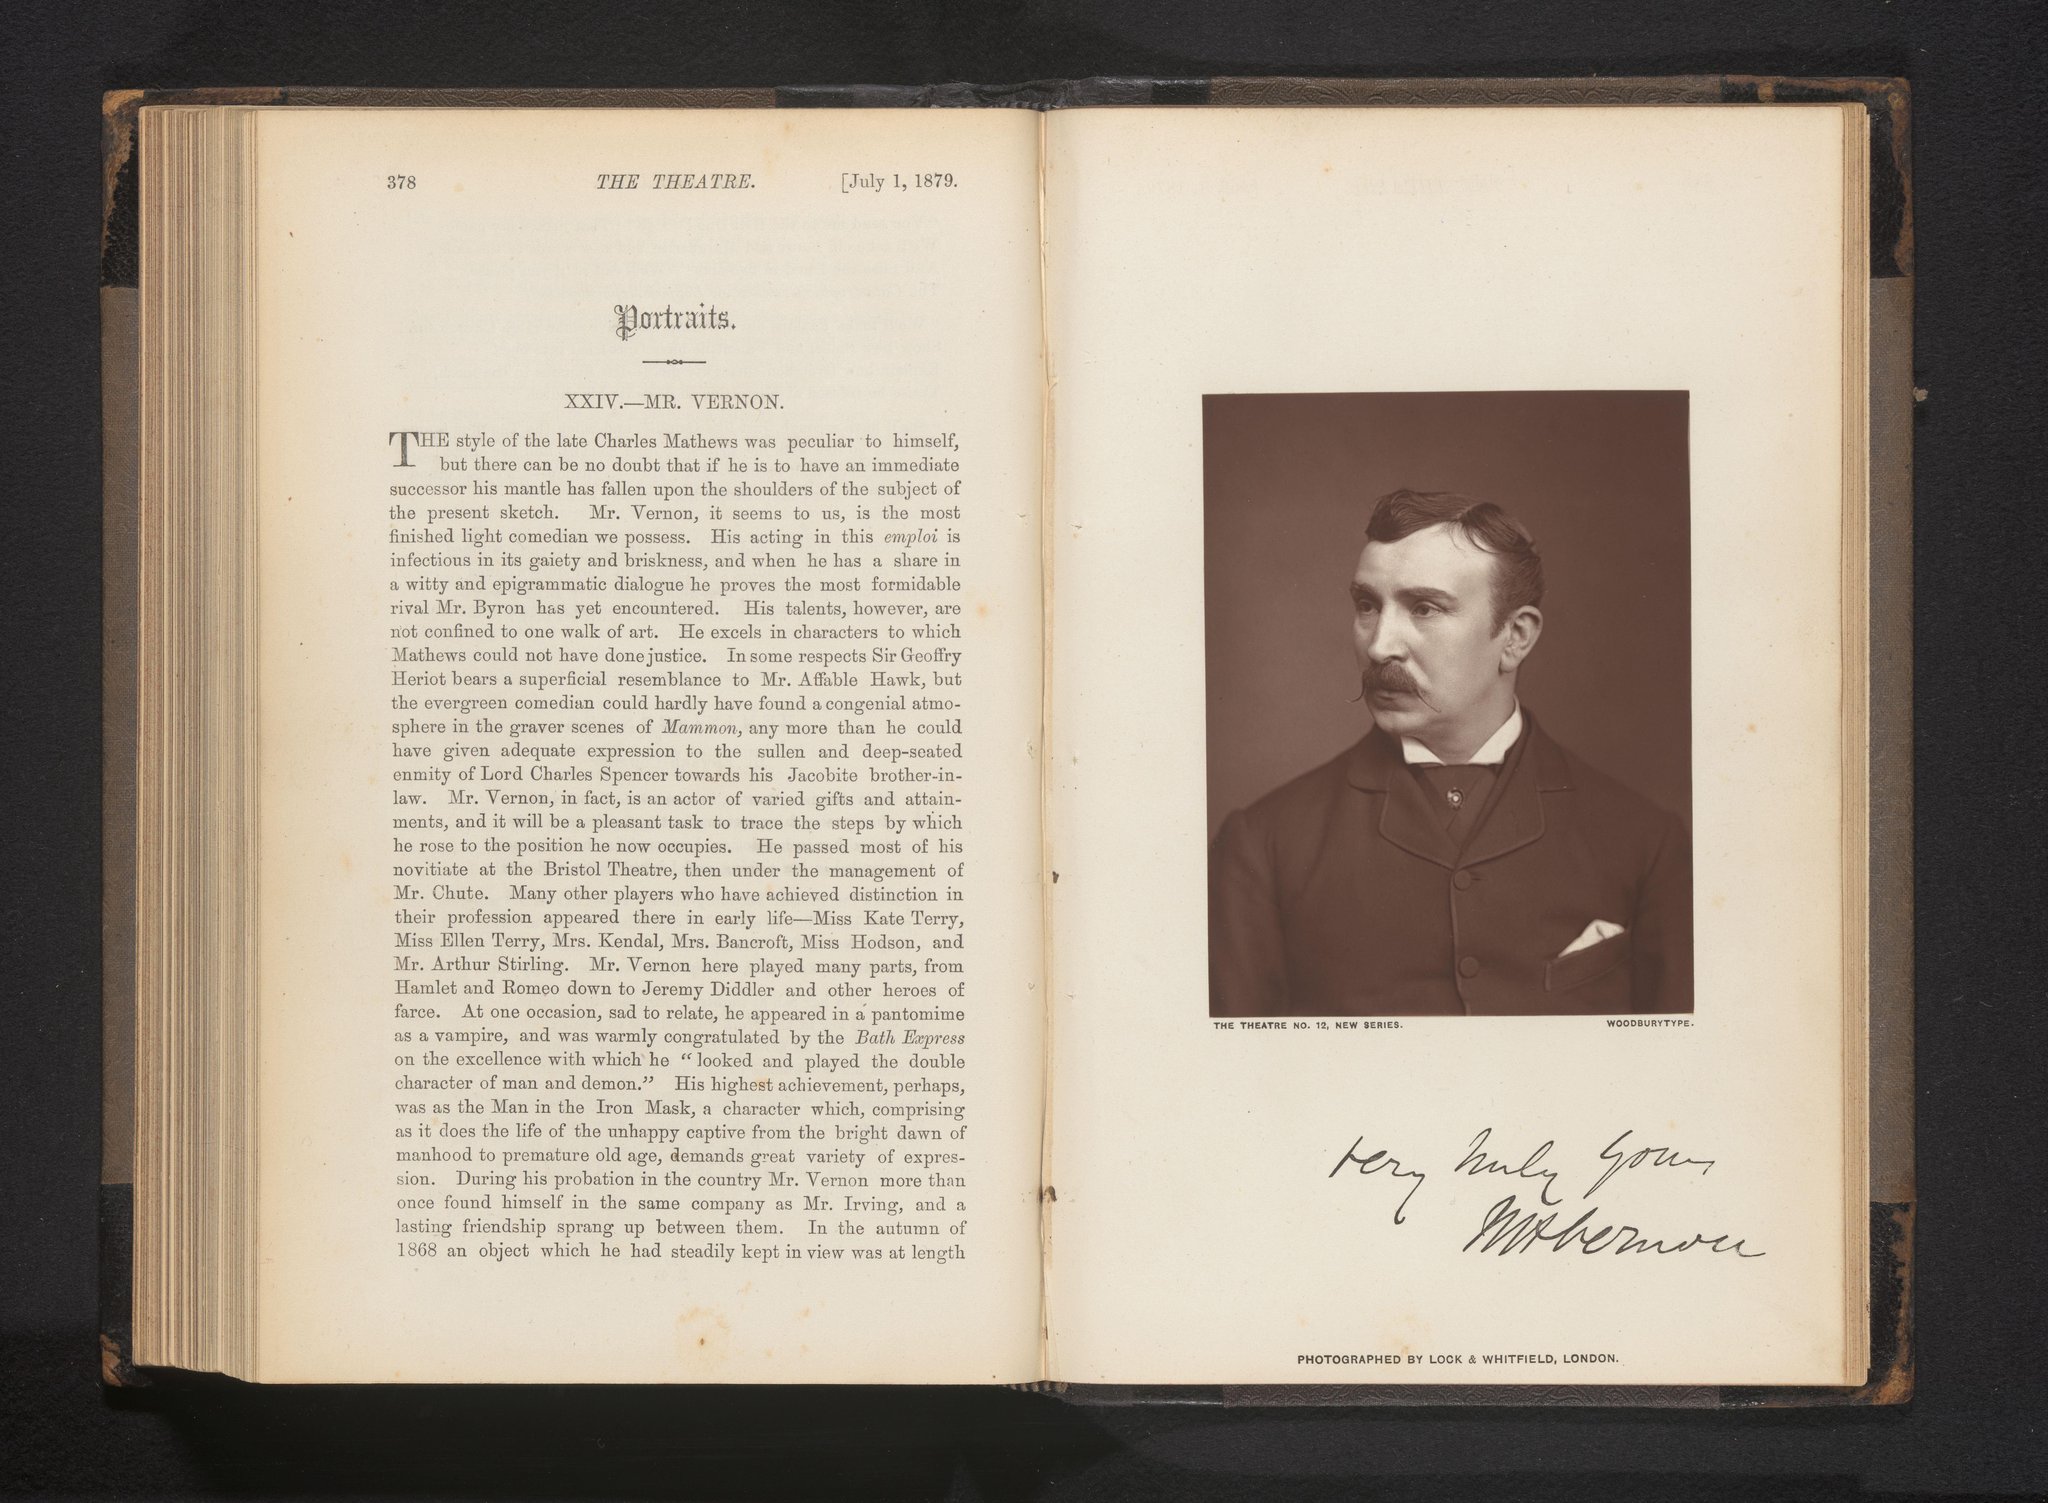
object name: photomechanical print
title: Portret van Mr. Vernon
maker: Anonymous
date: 1874-1879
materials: paper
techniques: woodburytype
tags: adult woman, historical persons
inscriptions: signature: ‘Very truly yours, M Vernon’